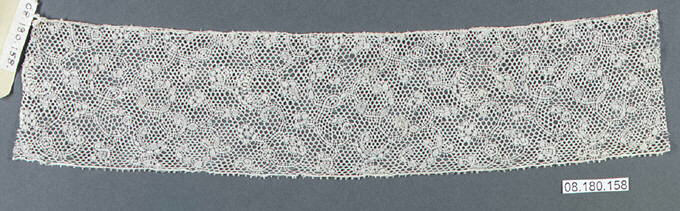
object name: piece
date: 1701-1733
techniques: lace